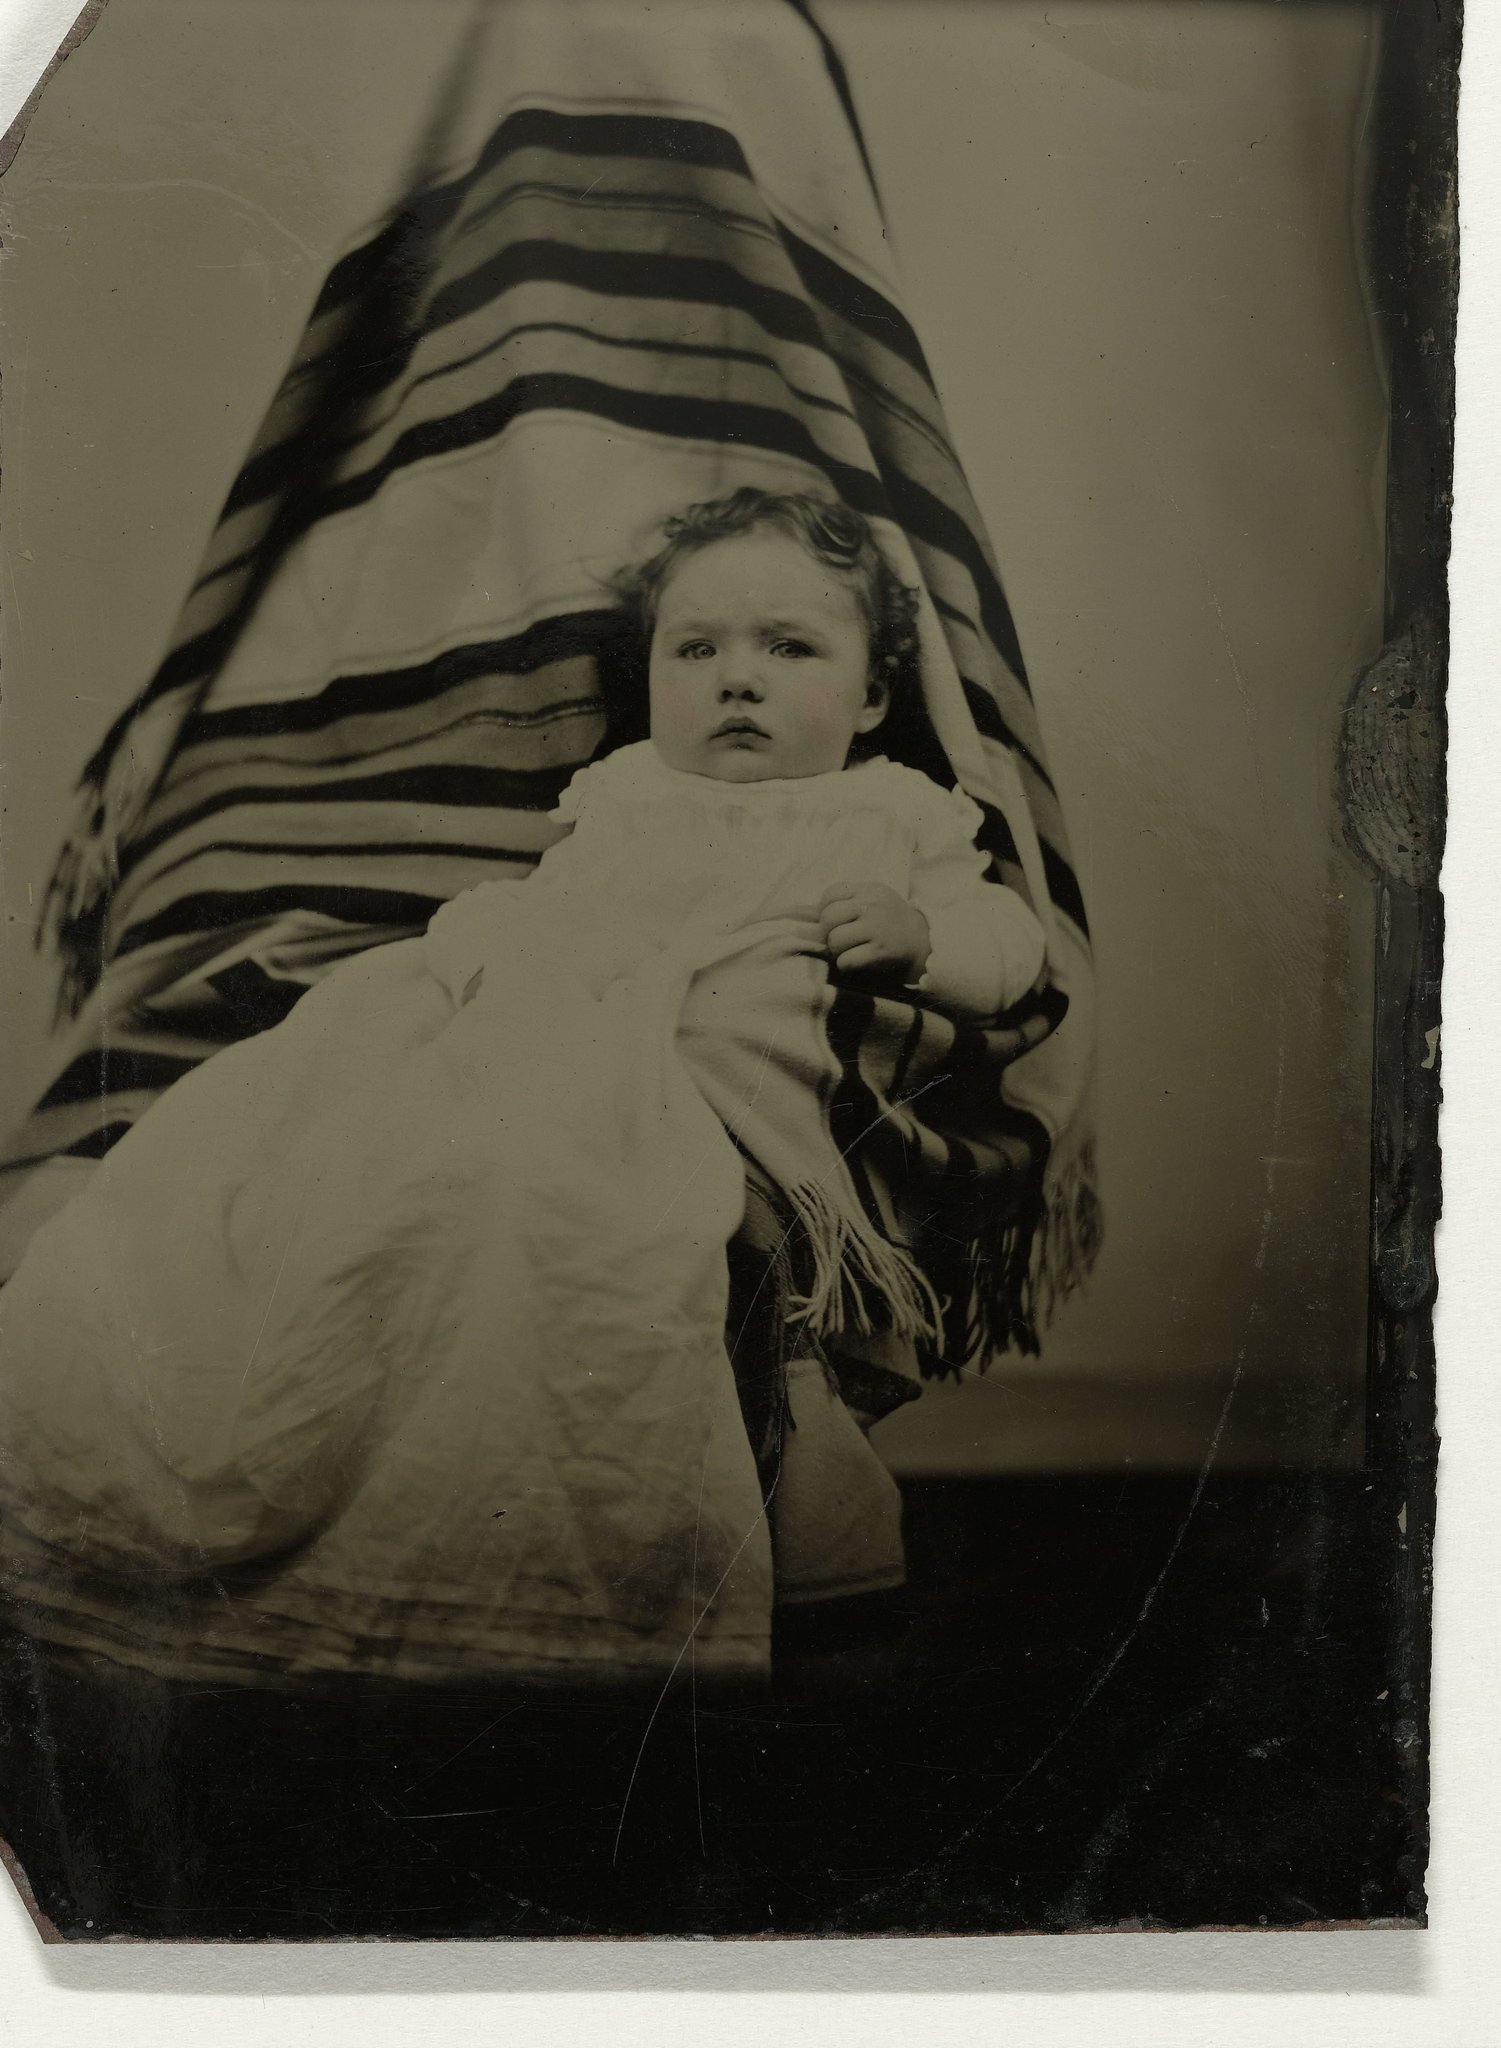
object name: photograph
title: Portret van een meisje, met achter haar onder een doek verborgen haar moeder ("hidden mother")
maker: Anonymous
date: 1880-1910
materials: metal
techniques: ferrotyping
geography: united states